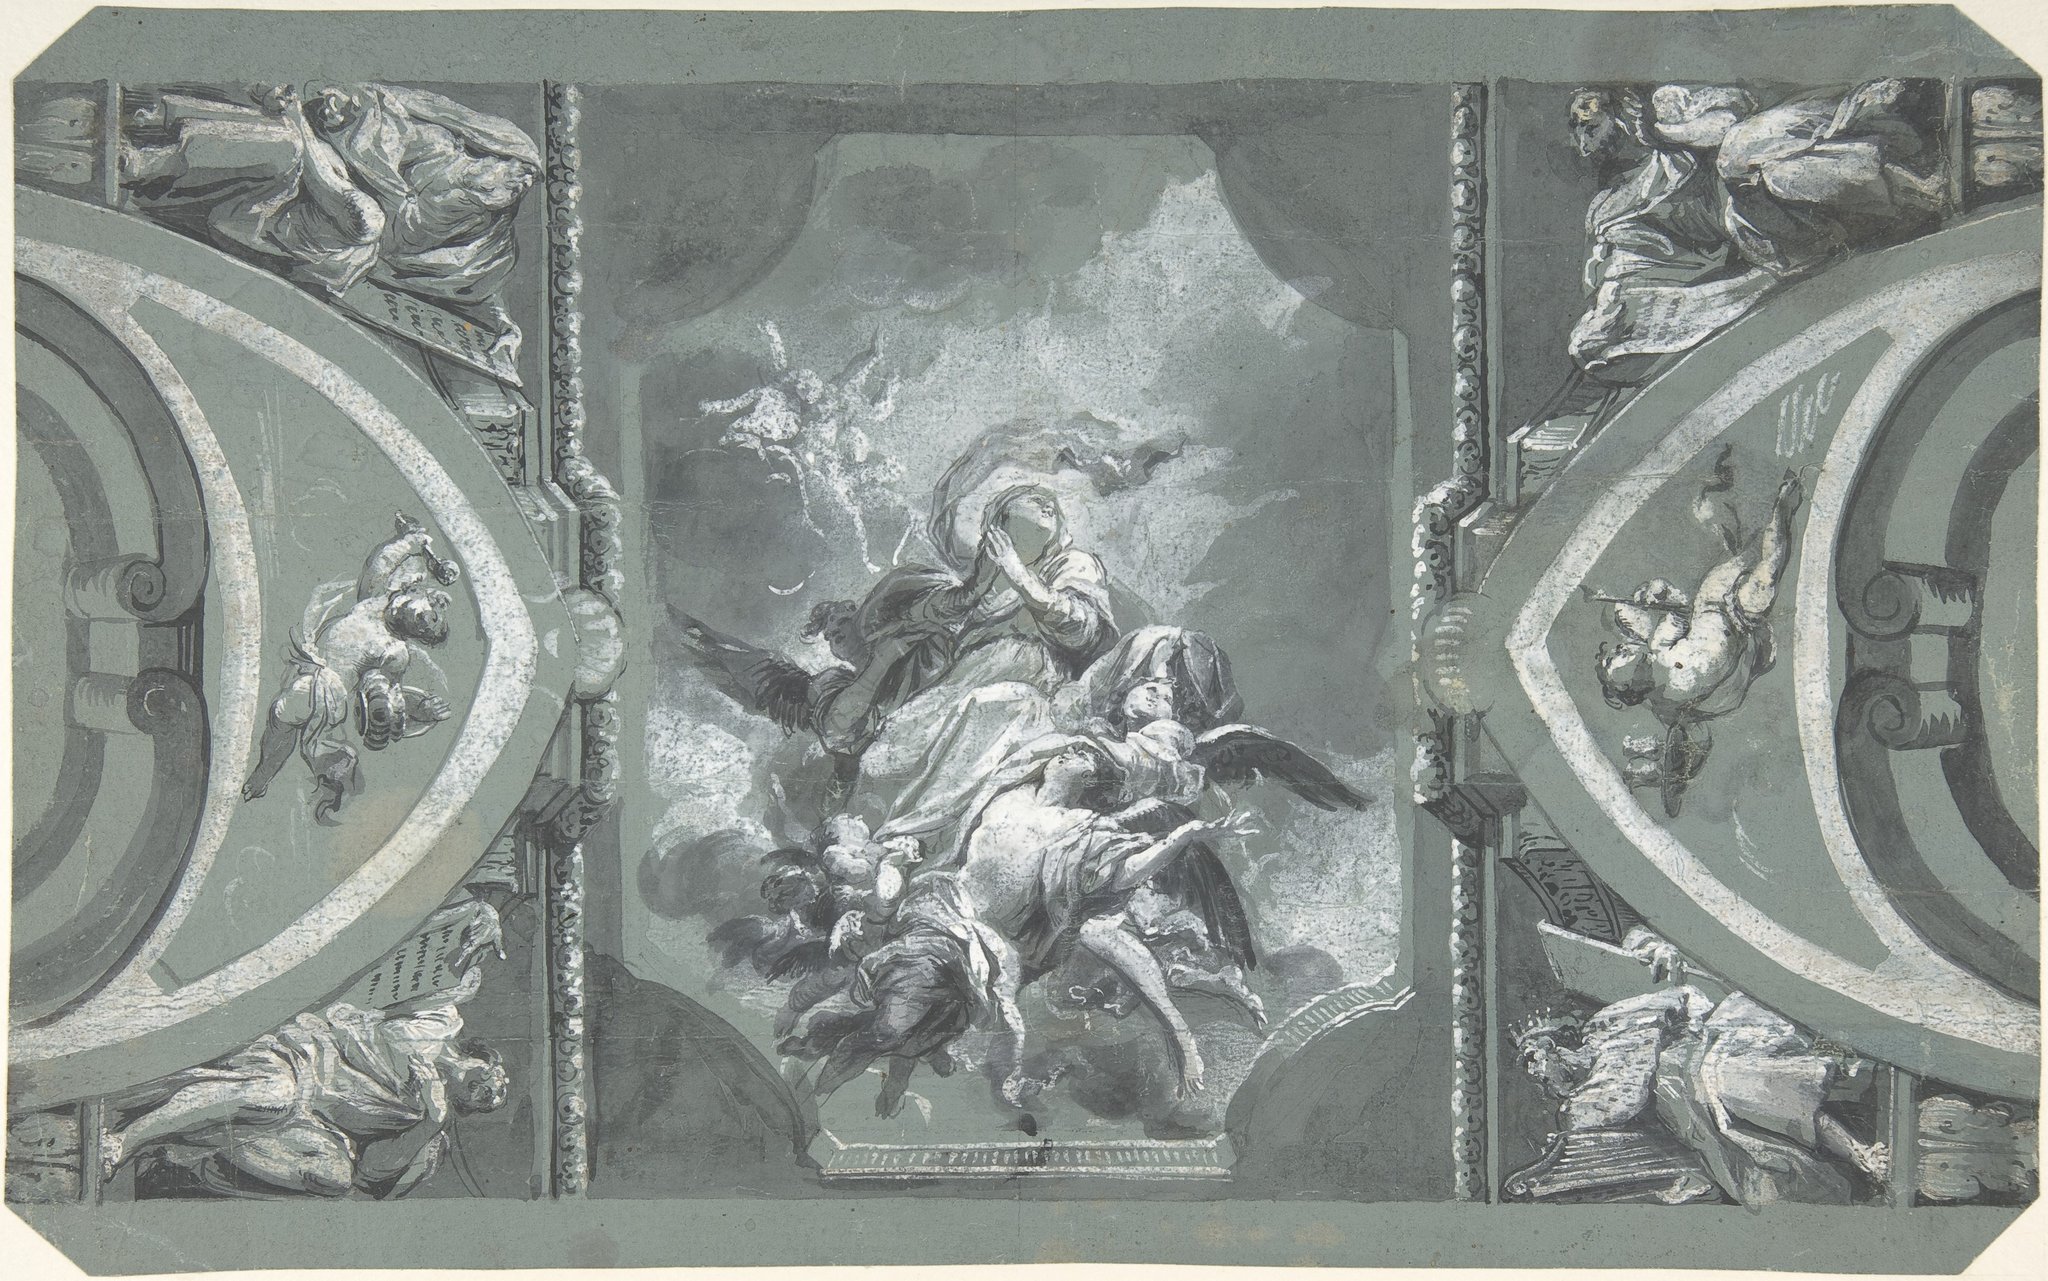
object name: drawing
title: Study for the Decoration of a Vault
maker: carlo alberto baratta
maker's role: artist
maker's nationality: italian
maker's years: 1754-1815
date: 1754-1815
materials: chalk, gouache, paper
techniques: brush, highlighting, wash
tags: roofs,saint anne